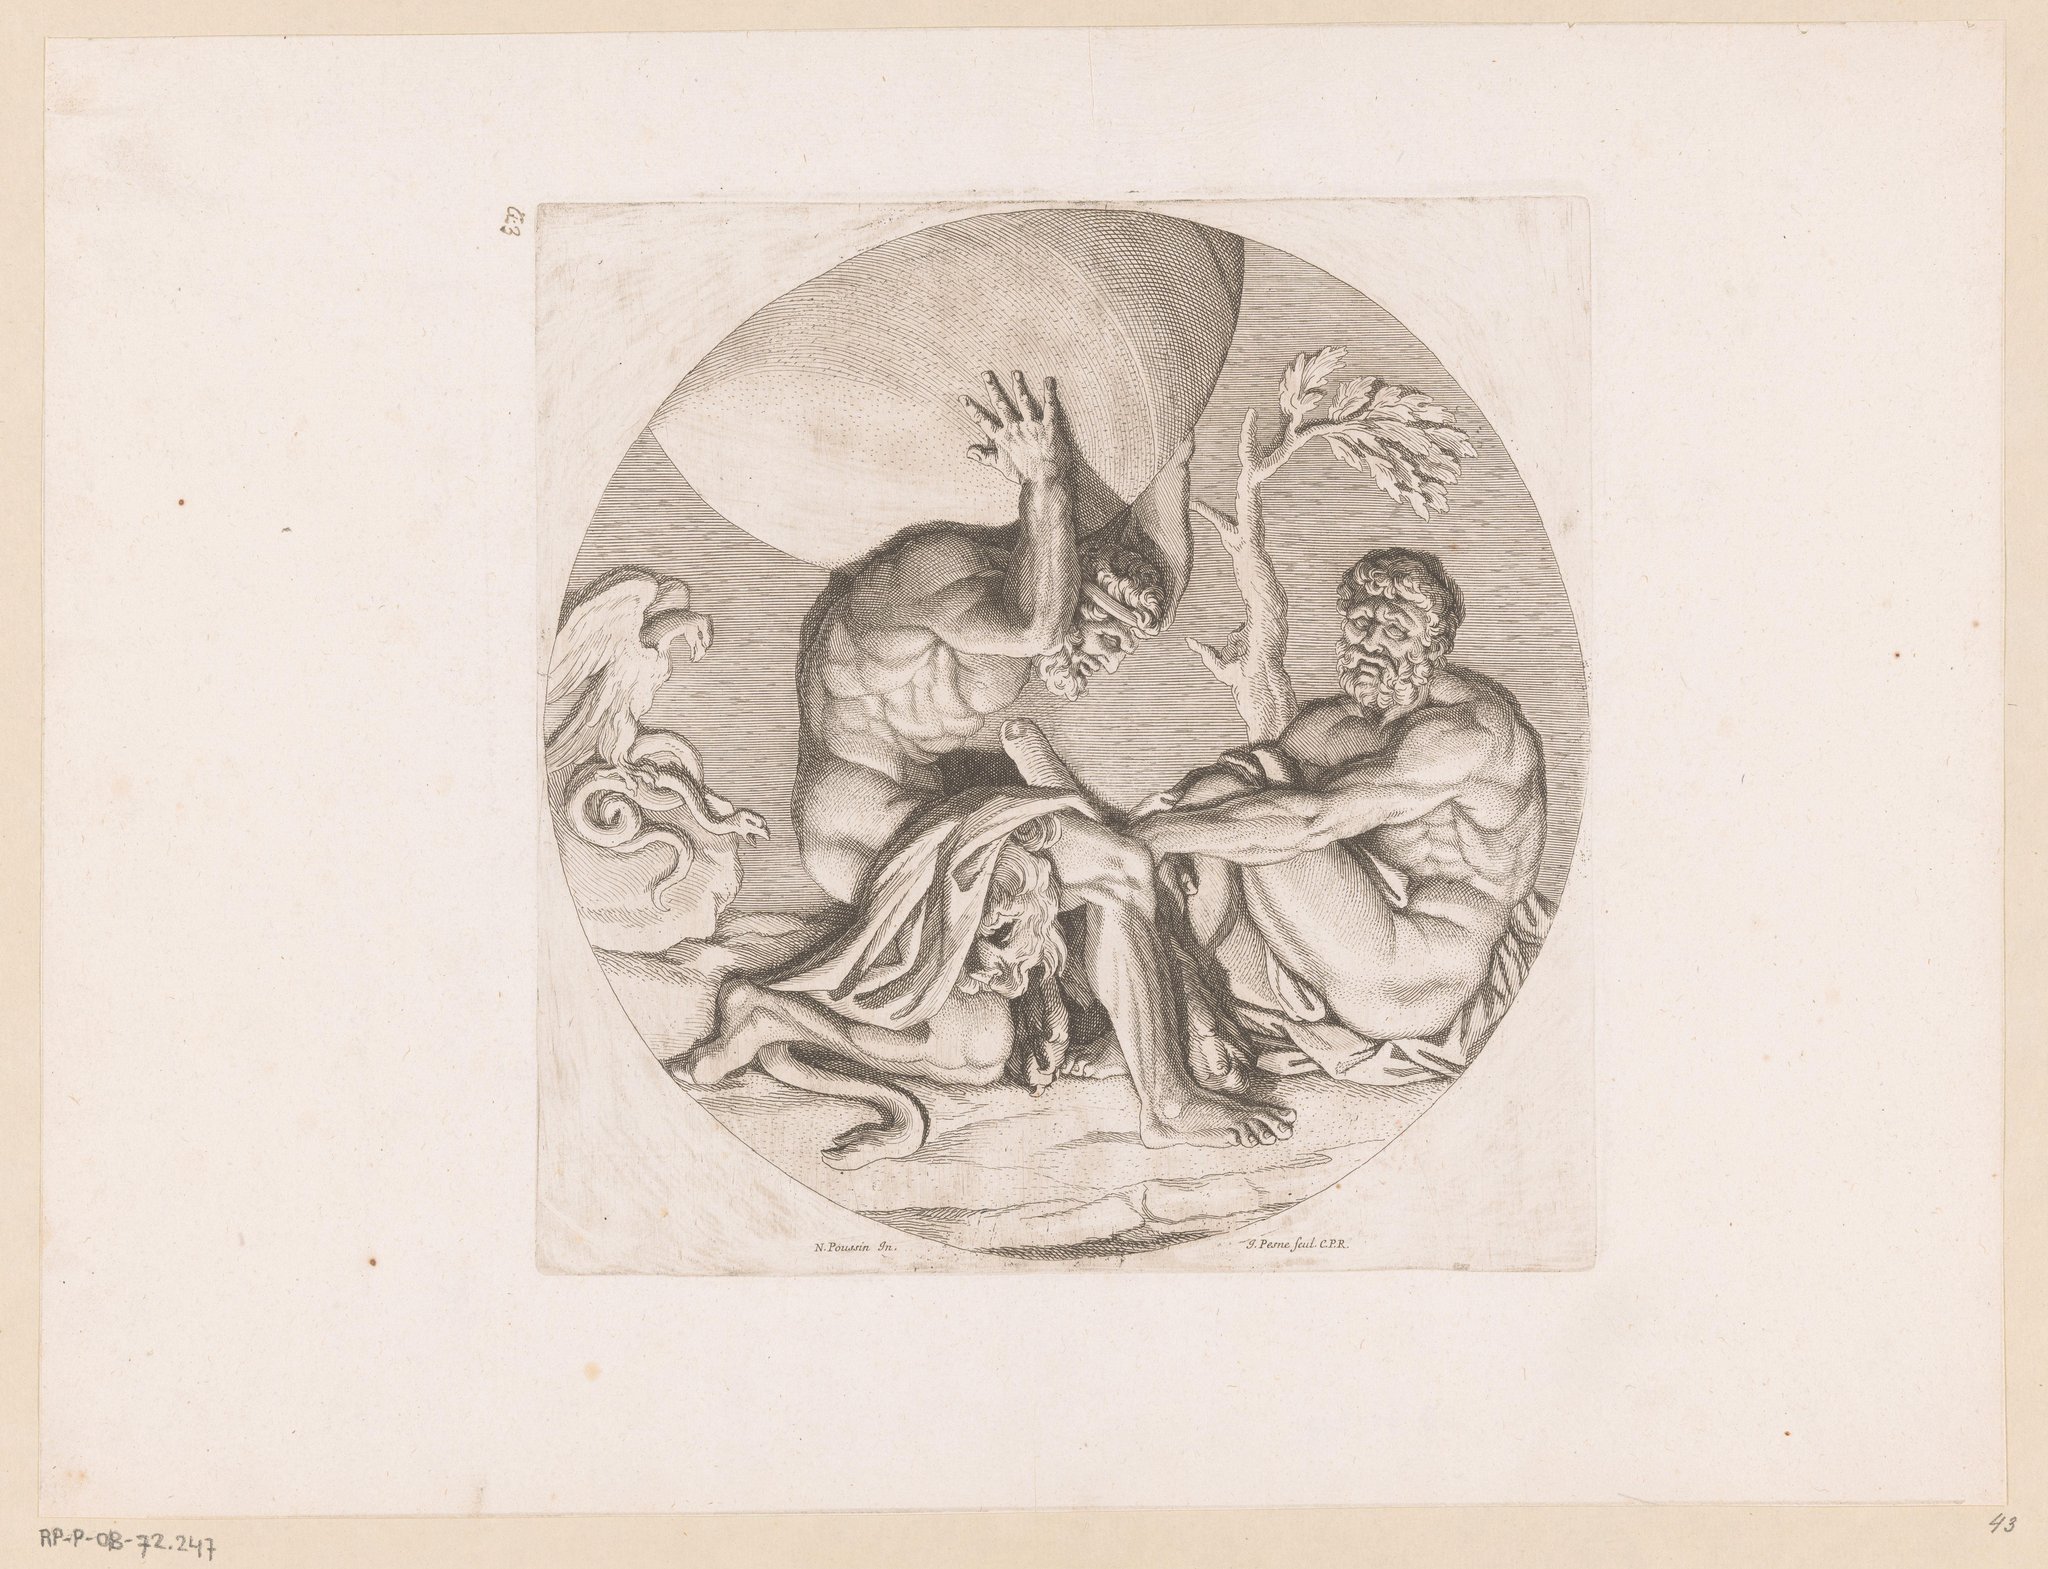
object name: print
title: Hercules en Atlas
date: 1678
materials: paper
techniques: engraving, etching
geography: france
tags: hercules carries the heavens on his shoulders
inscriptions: collector's mark: Lugt 240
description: Prent maakt deel uit van een ongenummerde serie van negentien prenten.